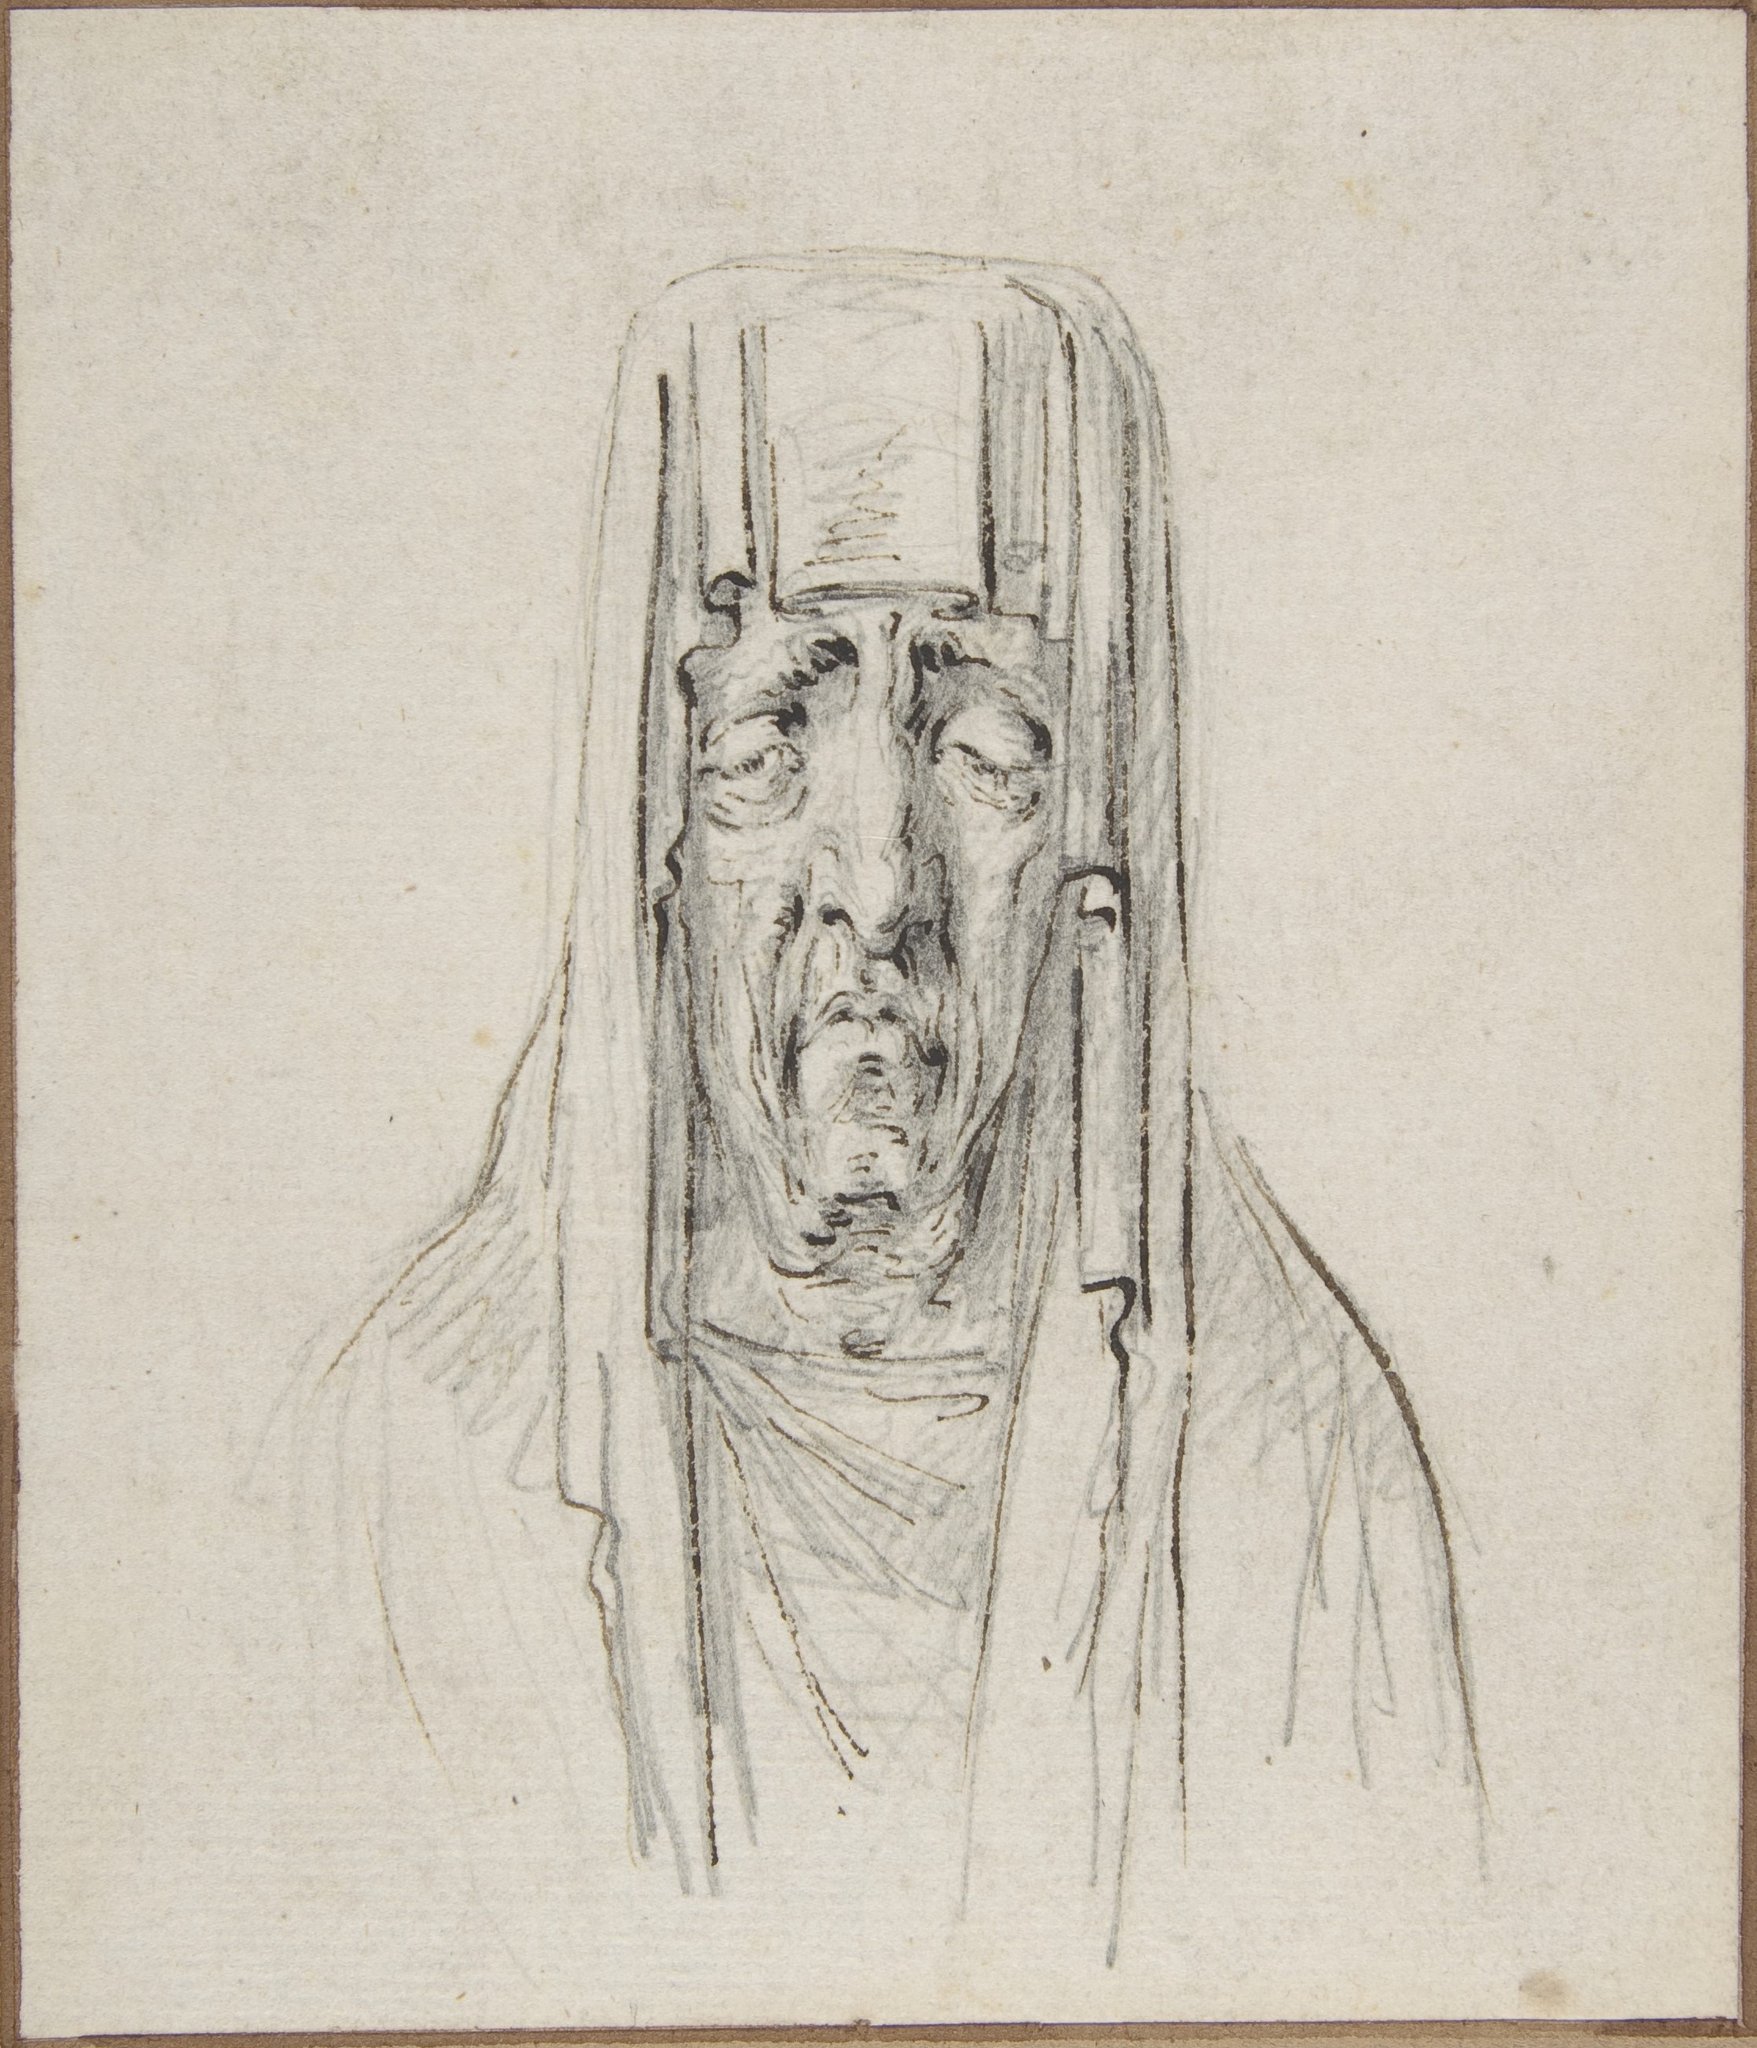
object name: drawing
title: Male Head in a Hood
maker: baron dominique vivant denon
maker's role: artist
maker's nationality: french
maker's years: 1747-1825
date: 1794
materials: chalk, ink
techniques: pen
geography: france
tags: heads,men